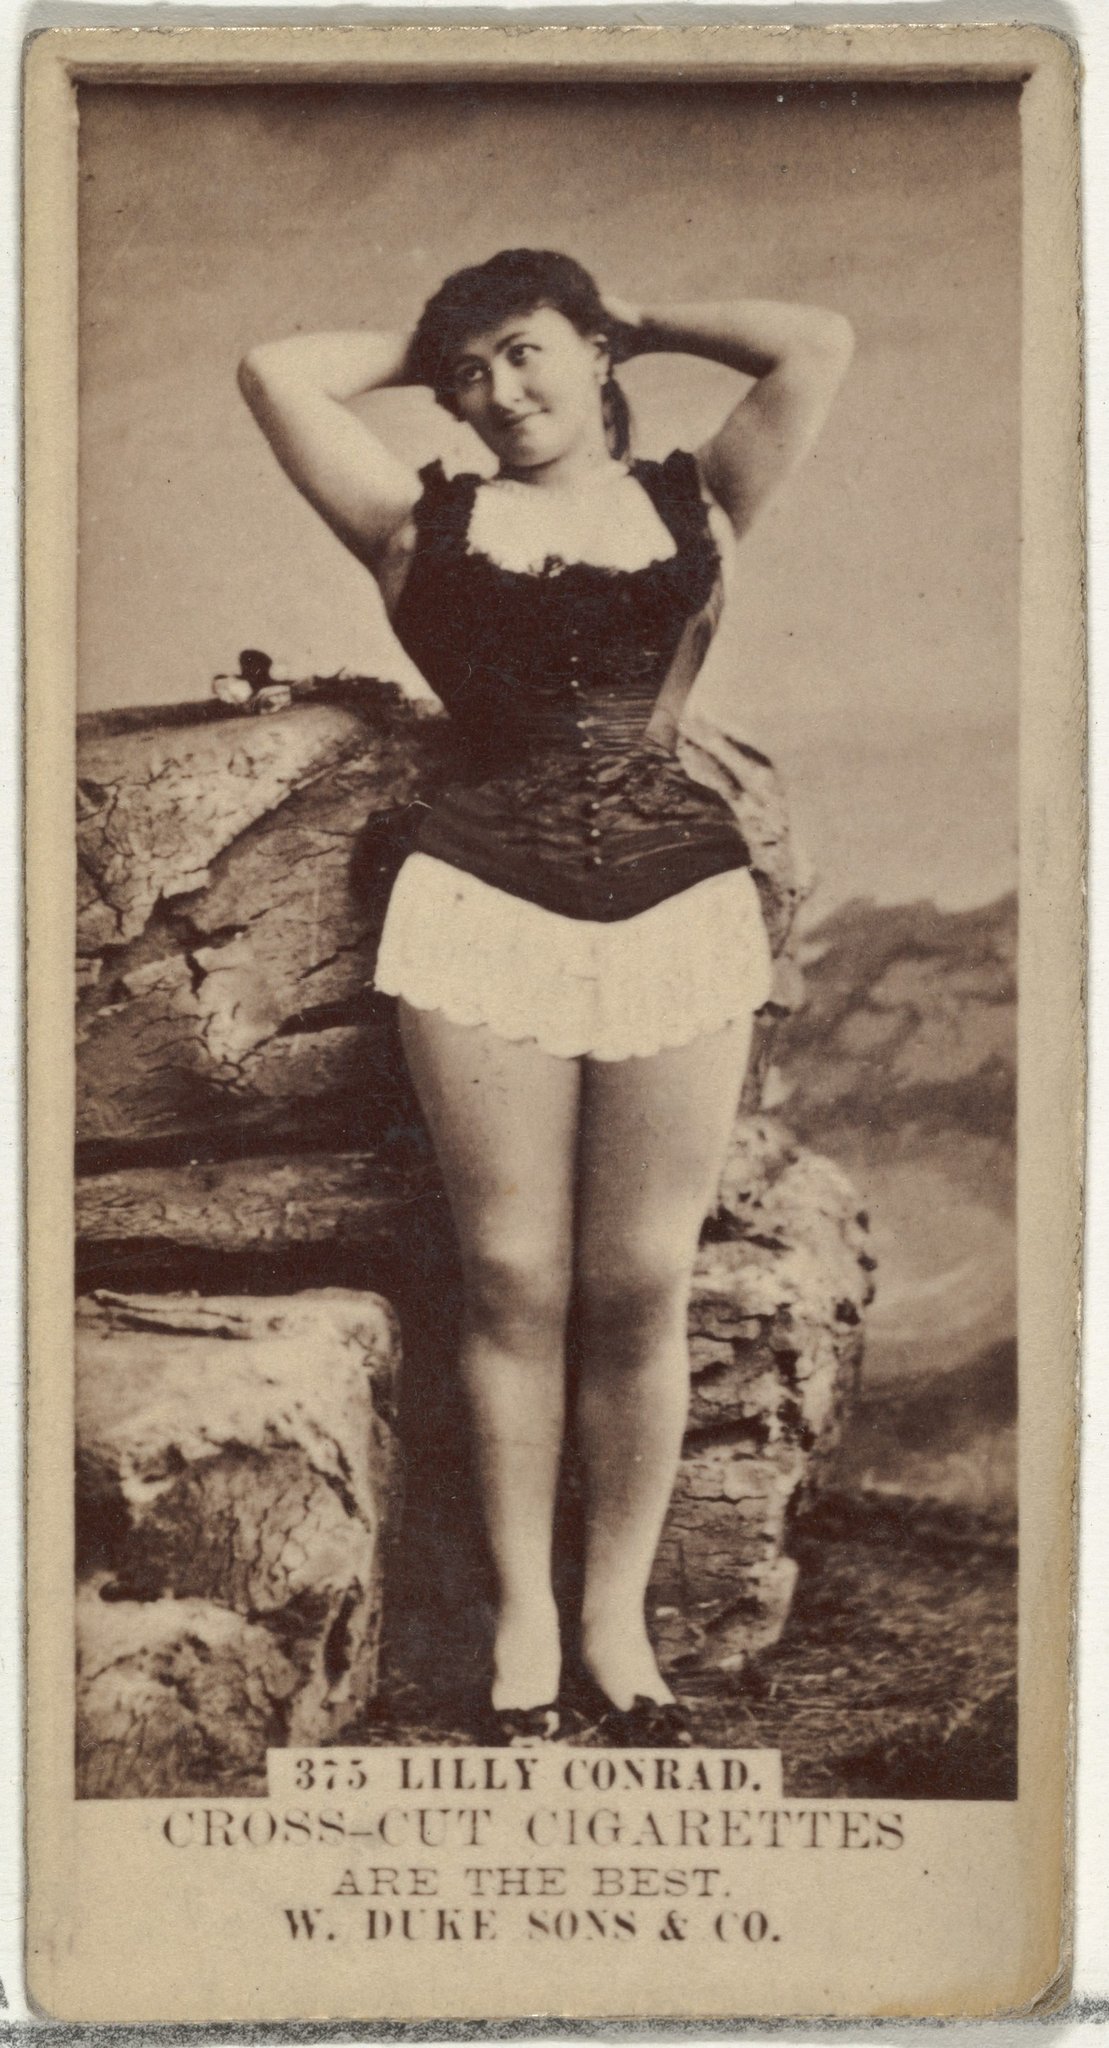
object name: photograph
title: Card Number 375, Lilly Conrad, from the Actors and Actresses series (N145-3) issued by Duke Sons & Co. to promote Cross Cut Cigarettes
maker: w. duke, sons & co.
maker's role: publisher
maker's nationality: american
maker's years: 1870-1920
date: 1880-1889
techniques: albumen silver print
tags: portraits,women,actresses